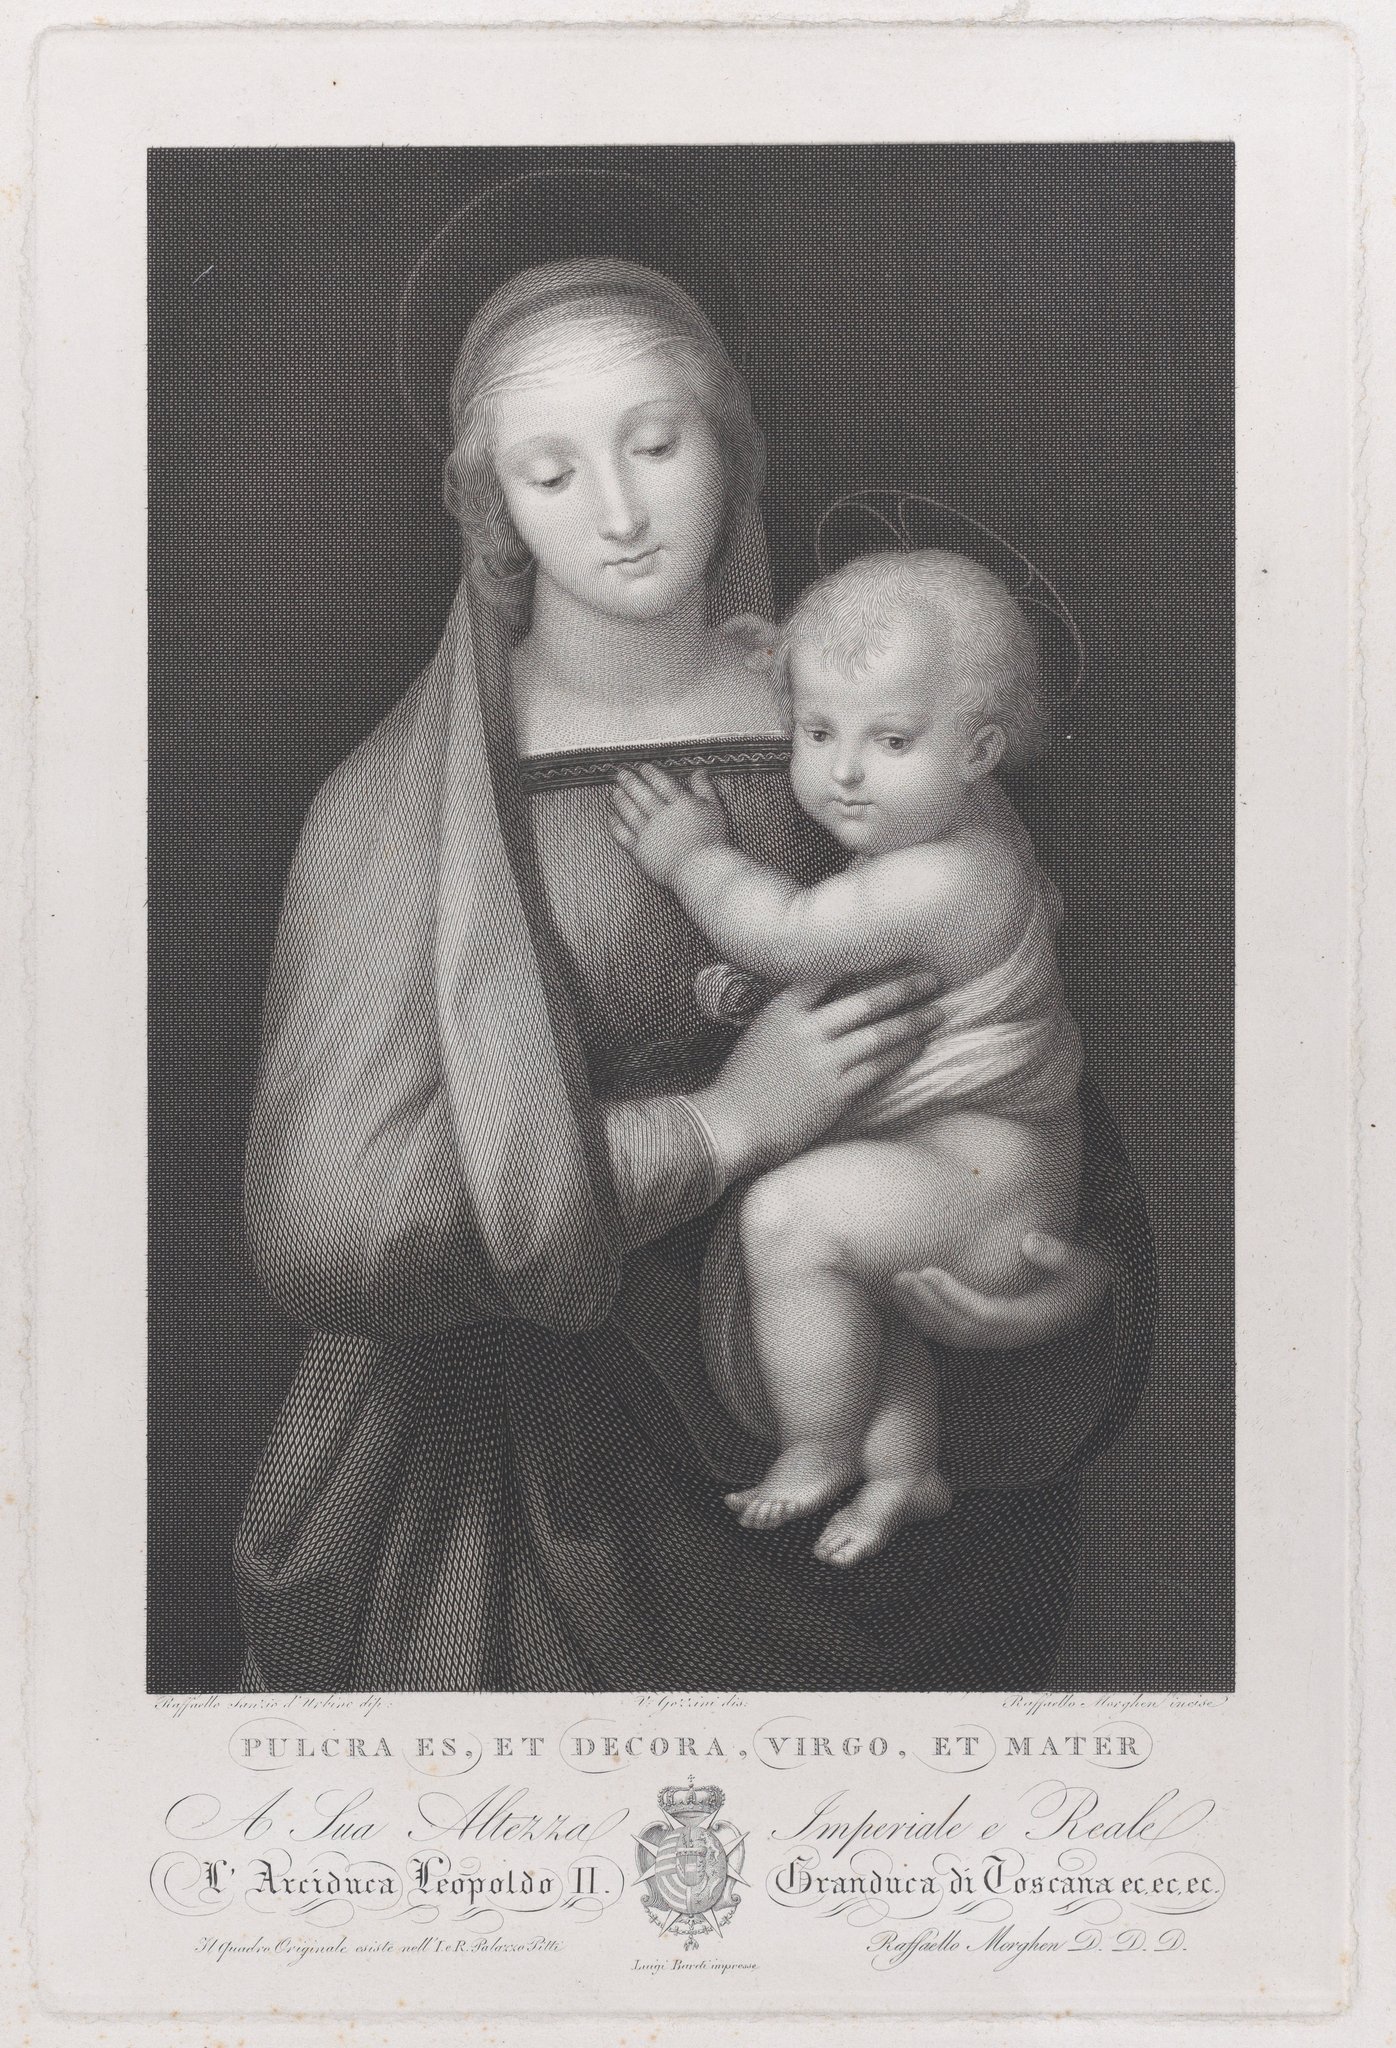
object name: print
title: Madonna del Granduca, the standing Virgin holding the Christ child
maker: raphael morghen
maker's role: artist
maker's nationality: italian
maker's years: 1758-1833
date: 1823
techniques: engraving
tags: madonna and child